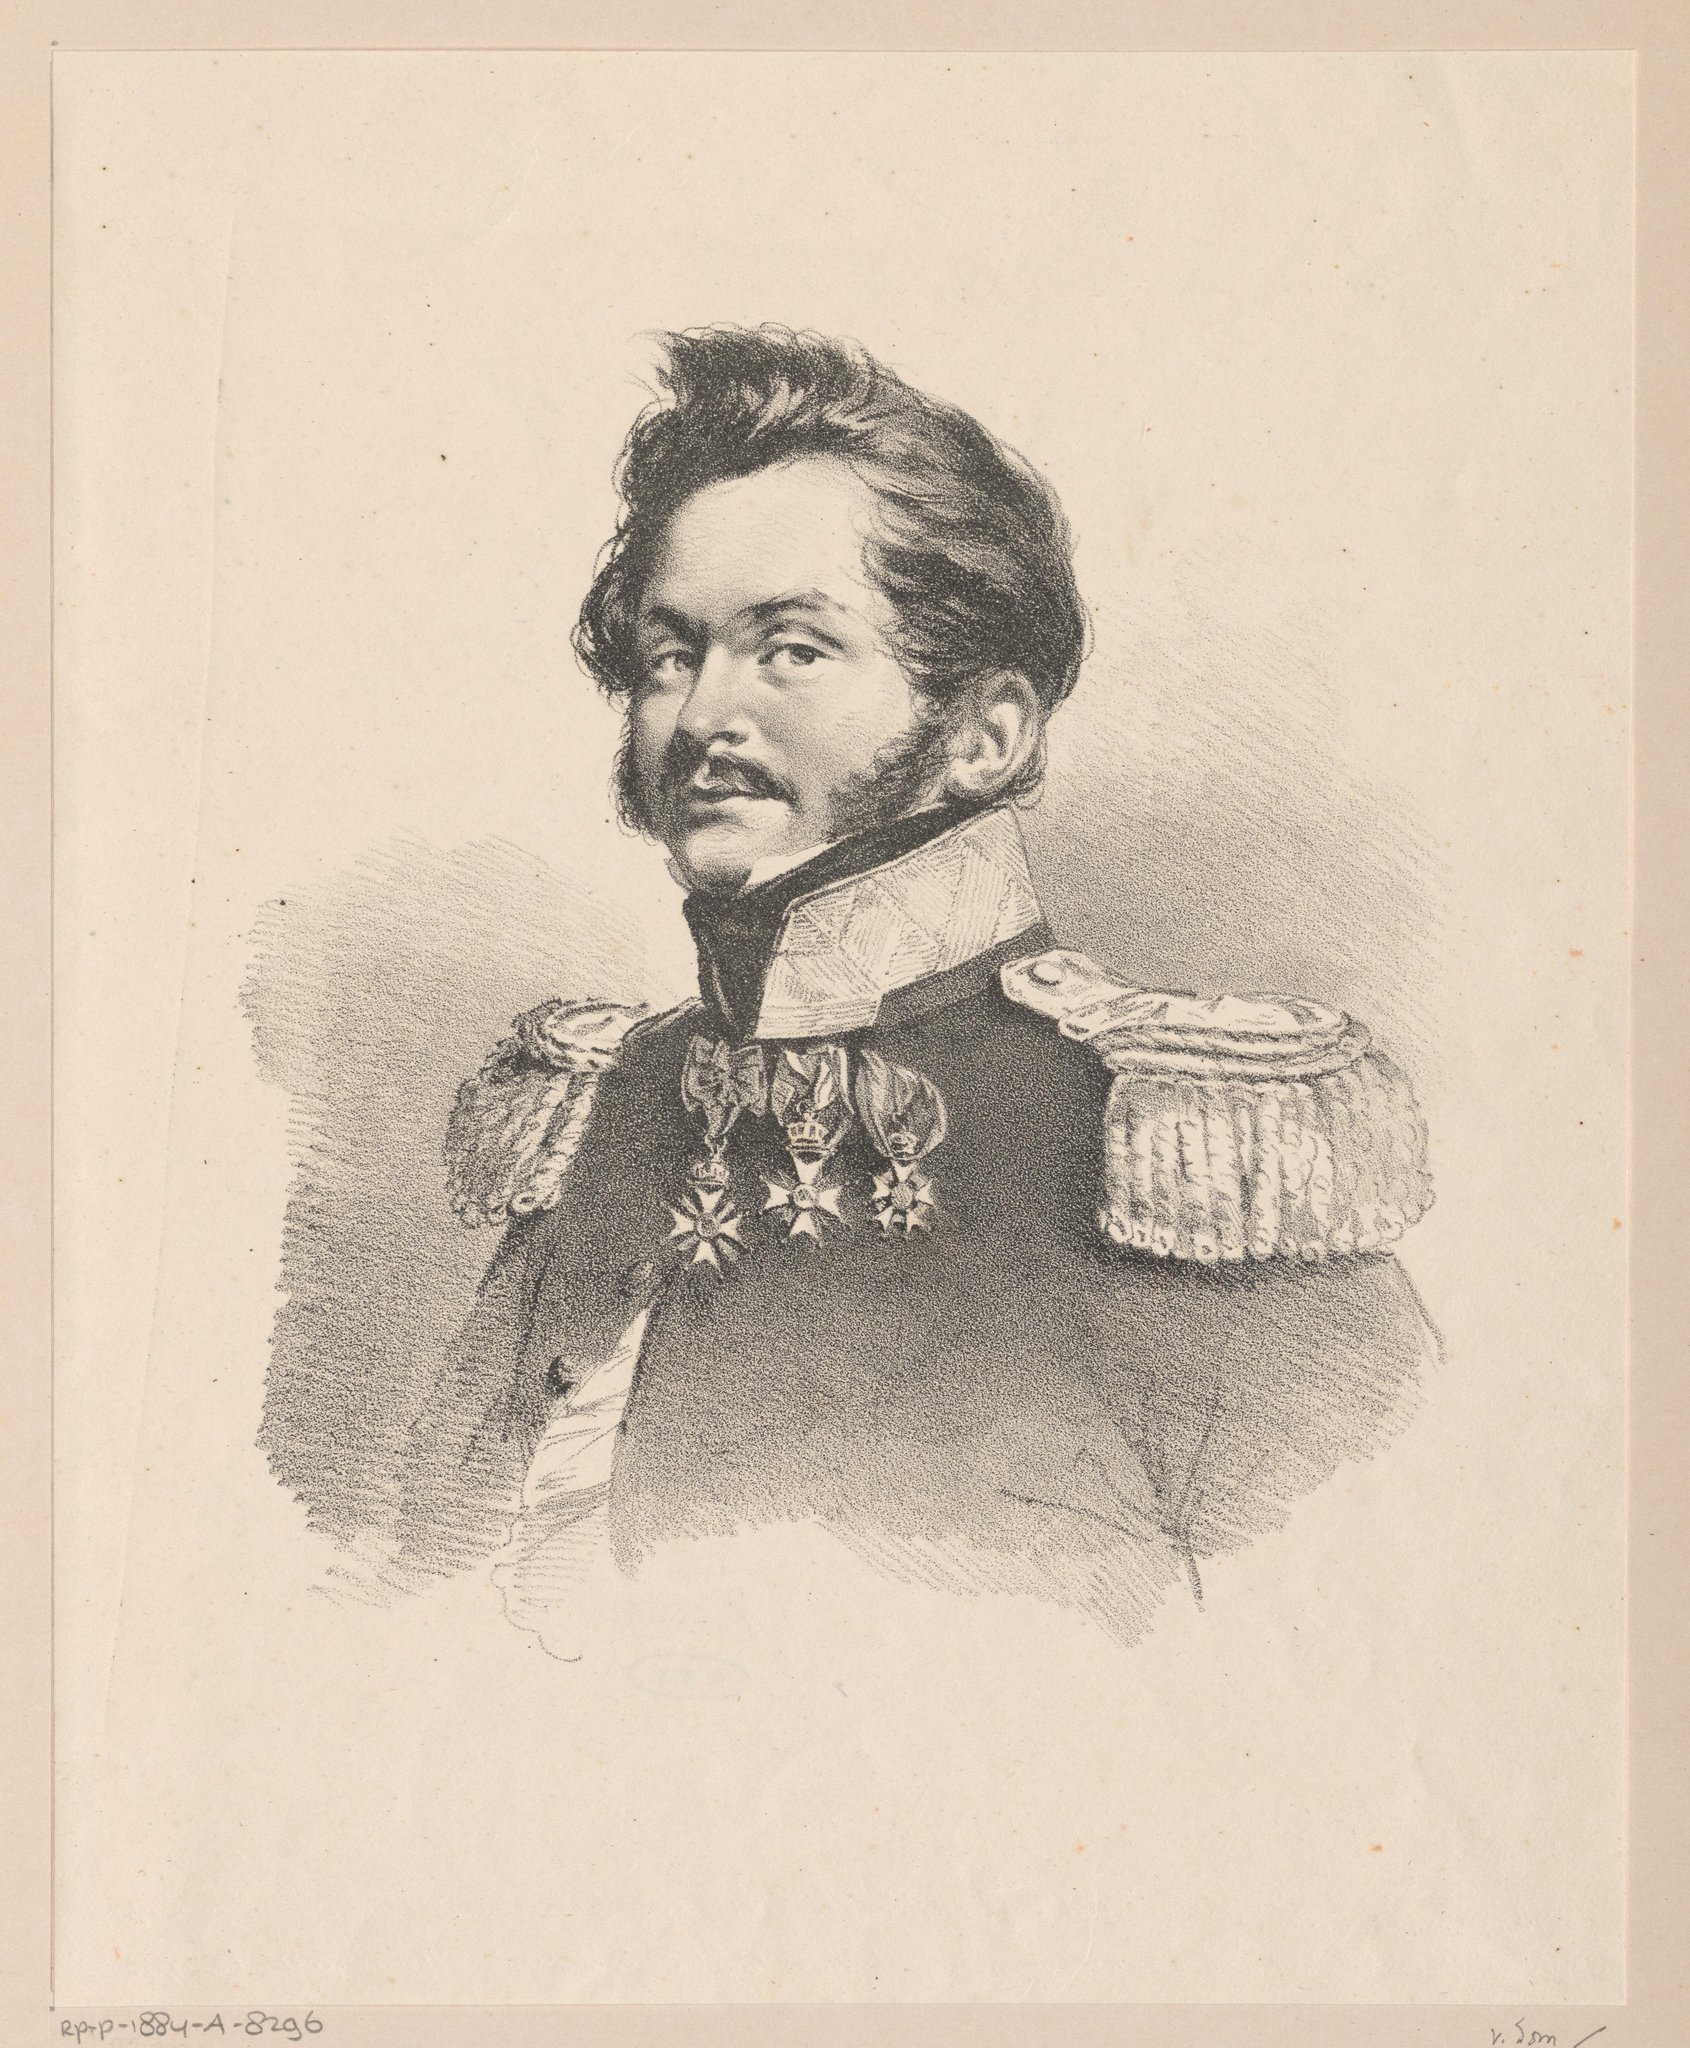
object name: print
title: Portret van Hubert Joseph Jean Lambert de Stuers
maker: jean augustin daiwaille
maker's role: draughtsman, print maker, printer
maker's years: 1786-1850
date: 1808-1850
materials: paper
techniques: lithograph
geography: netherlands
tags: maastricht, hubert joseph jean lambert de stuers, drawing, commander-in-chief, general, marshal, historical persons, medals and other marks of military honour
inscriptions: collector's mark: Lugt 2228